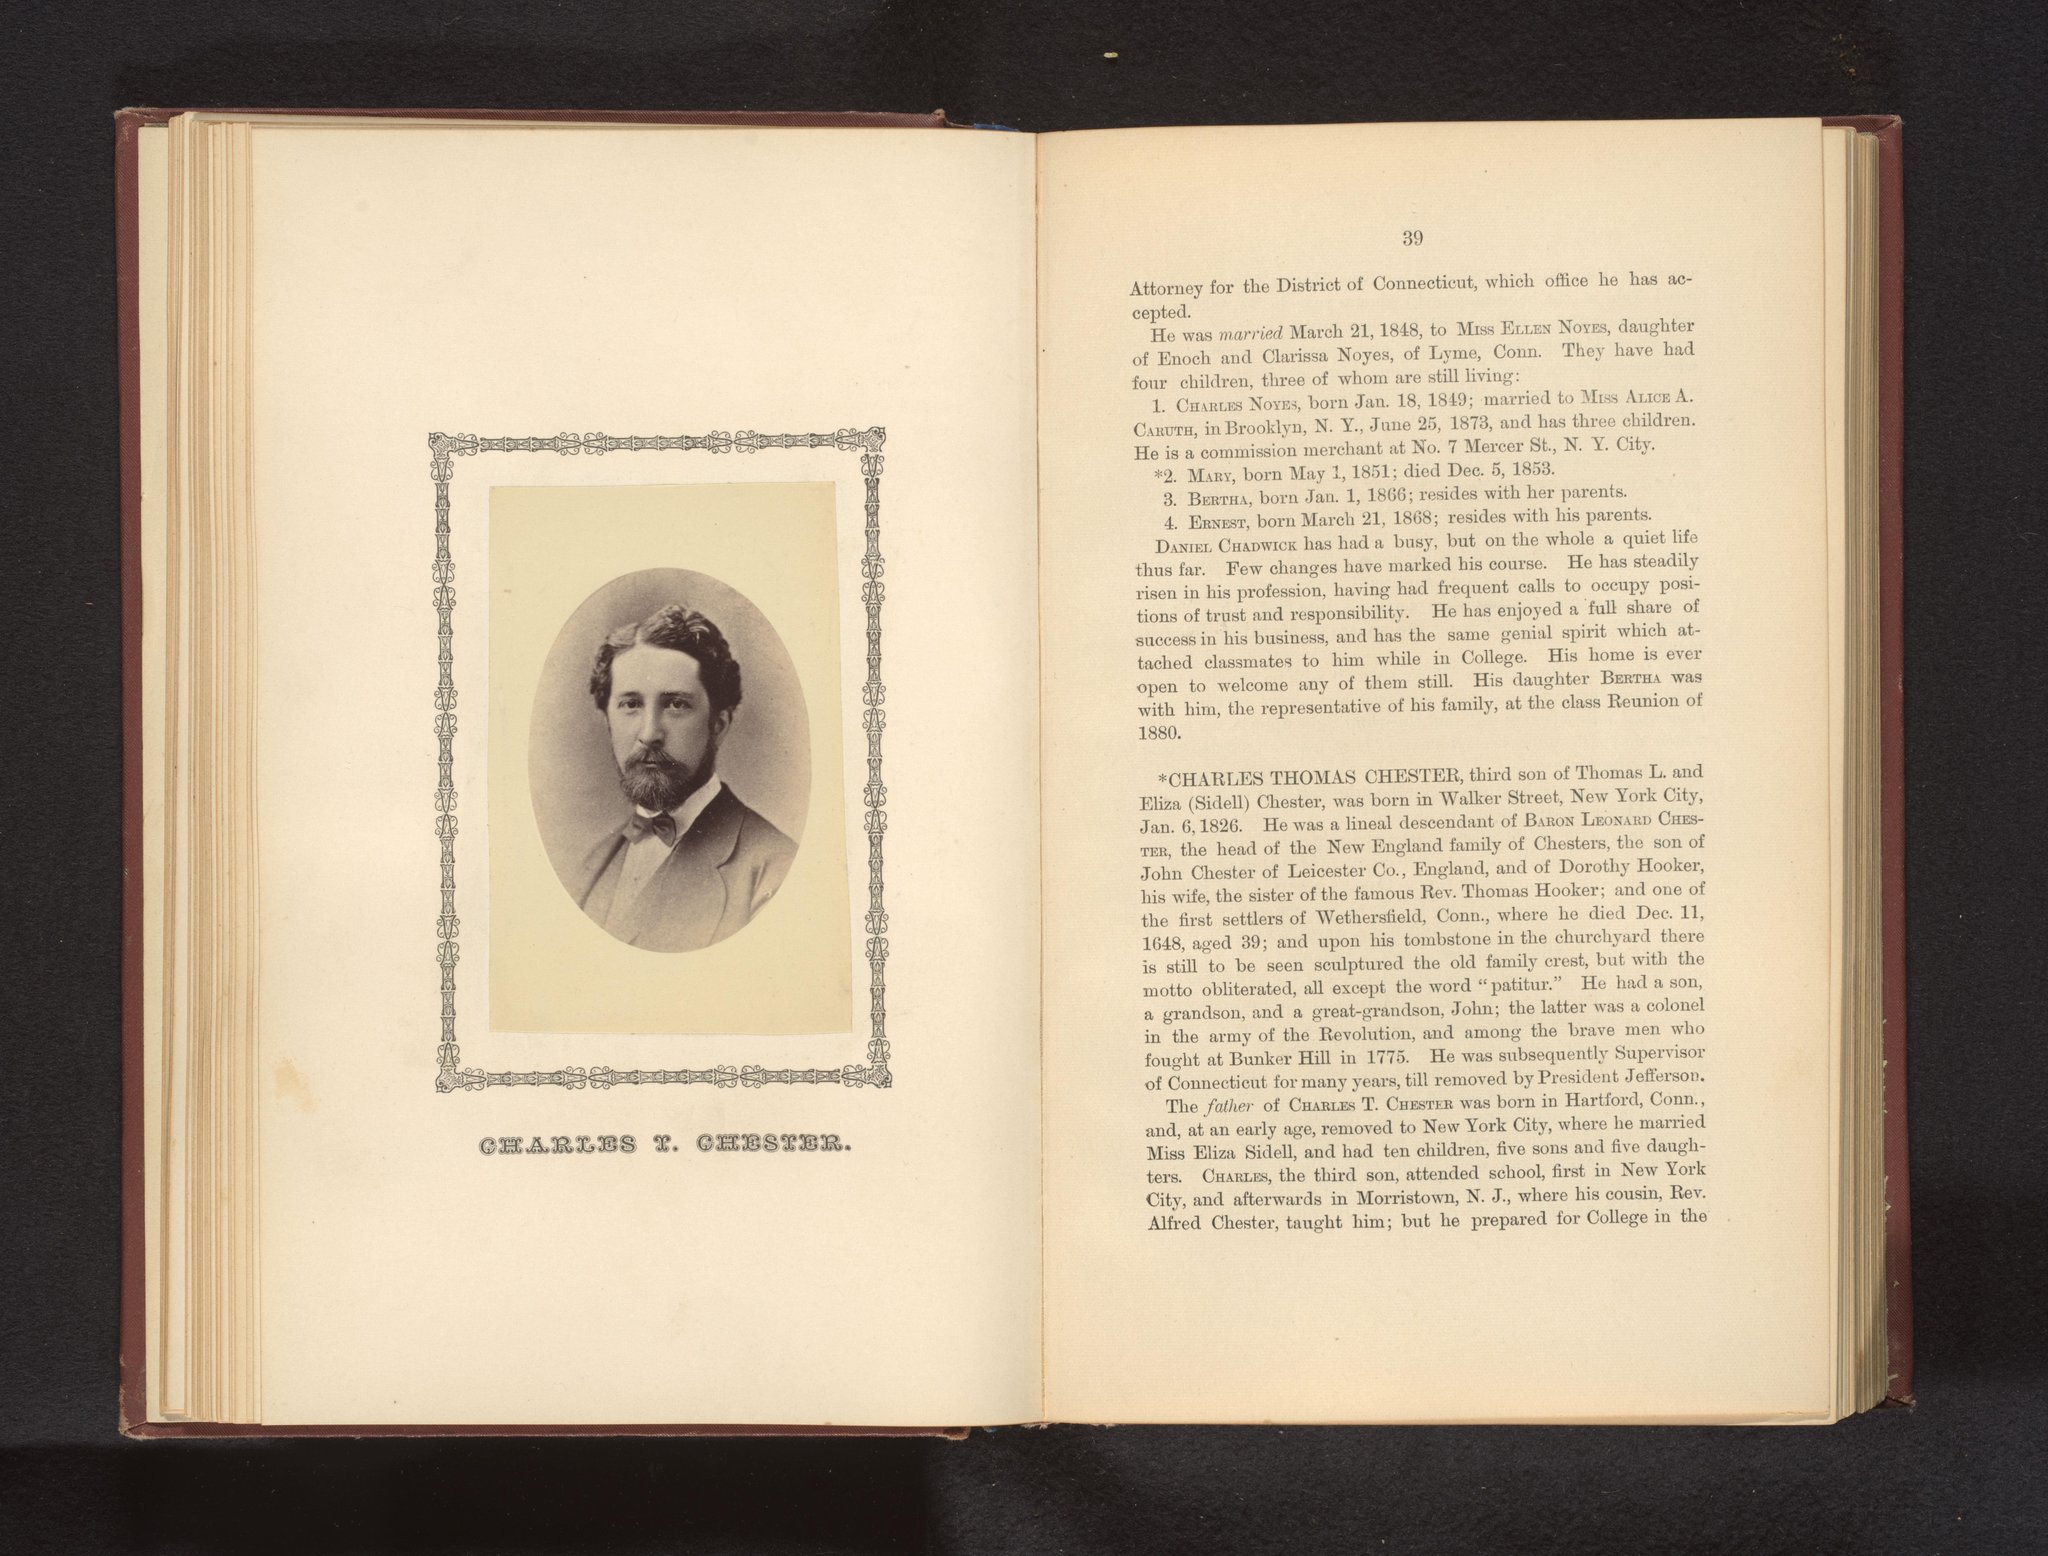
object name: photograph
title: Charles T. Chester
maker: Anonymous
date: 1876-1881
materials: photographic support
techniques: albumen print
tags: adult man